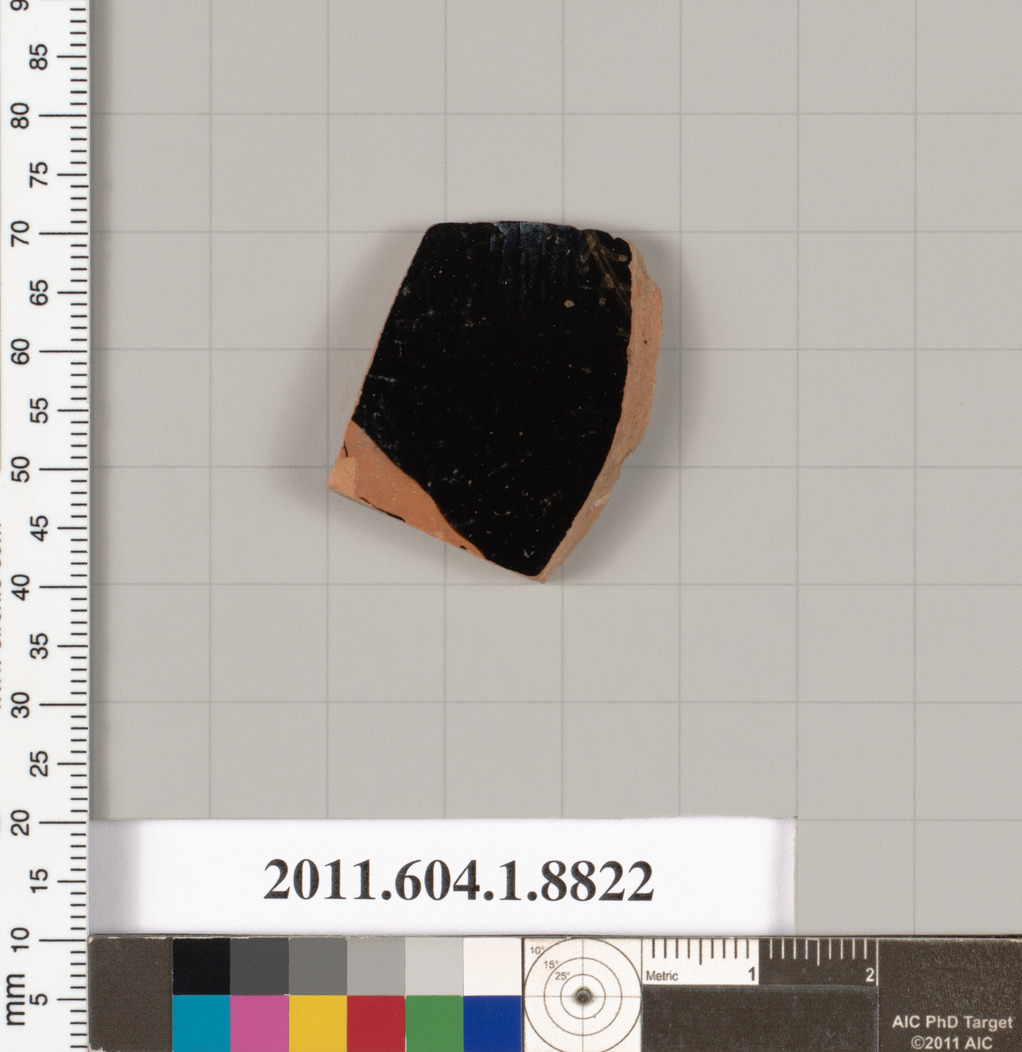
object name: kylix fragment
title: Terracotta fragment of a kylix (drinking cup)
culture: greek, attic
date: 490-470 BCE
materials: terracotta